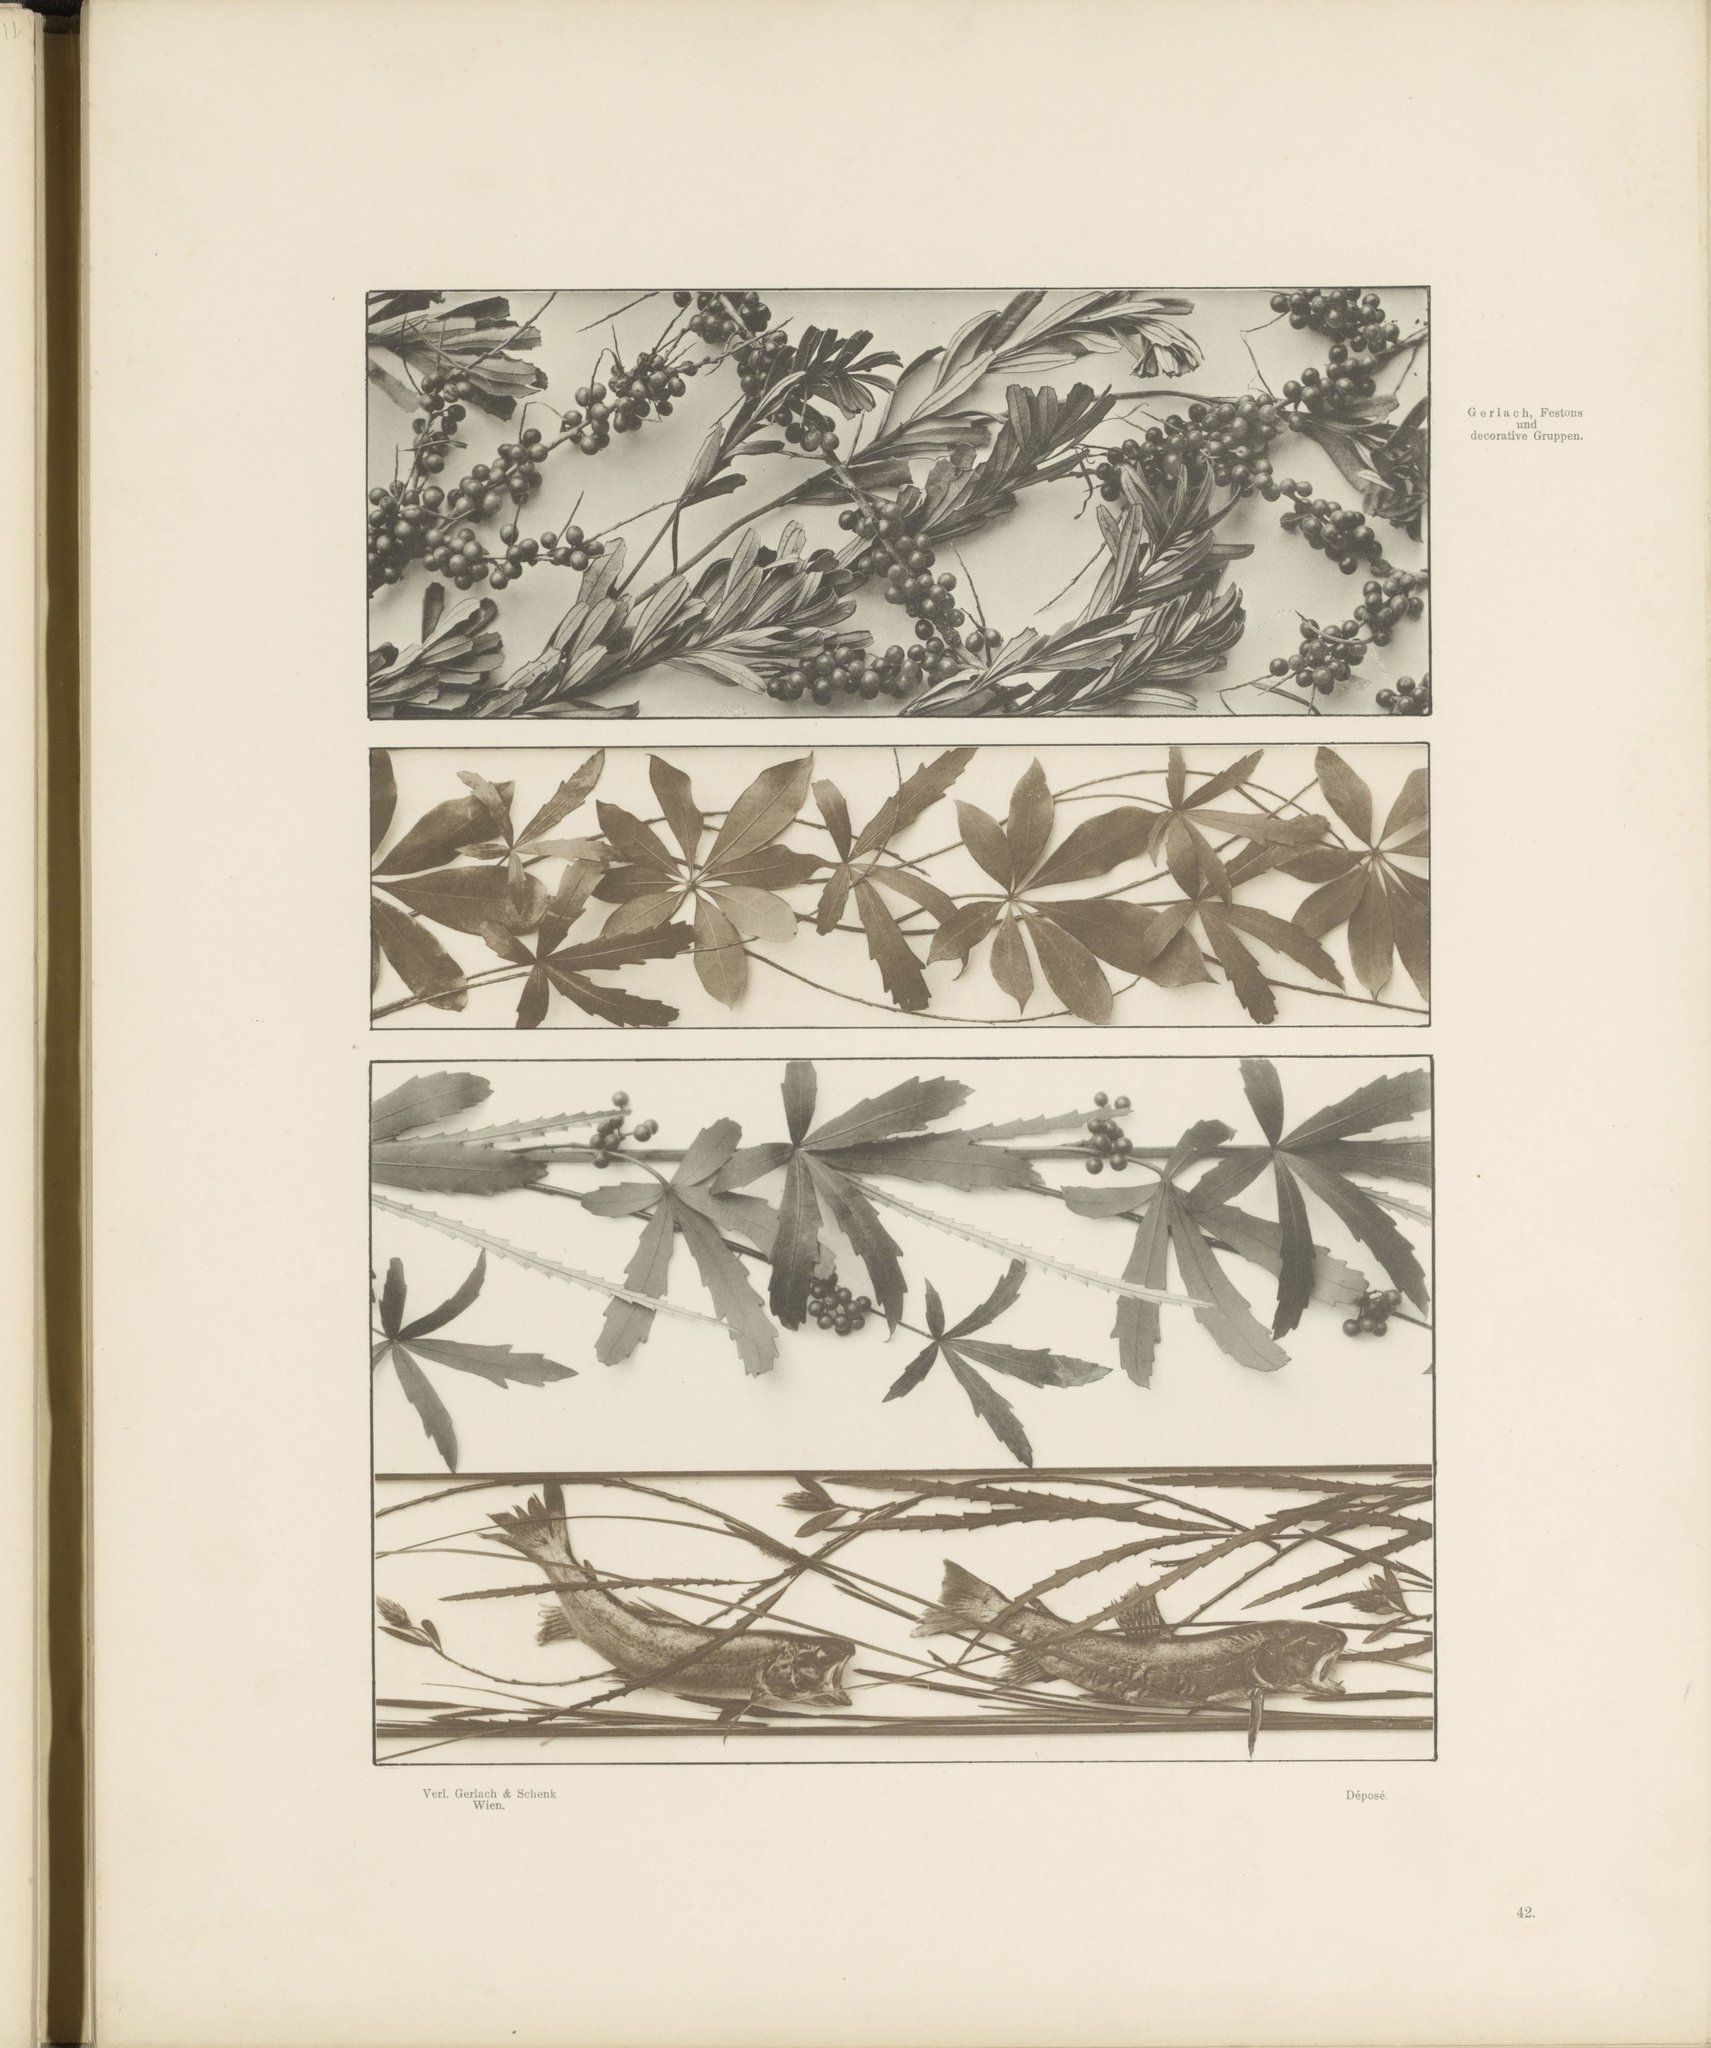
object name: photomechanical print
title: Drie friezen met vuurdoornbessen, forel en aralia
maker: Anonymous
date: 1887-1897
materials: paper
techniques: photograph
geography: austria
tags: fishes, foliage, tendrils, branches ~ ornament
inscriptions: number: ‘42.’